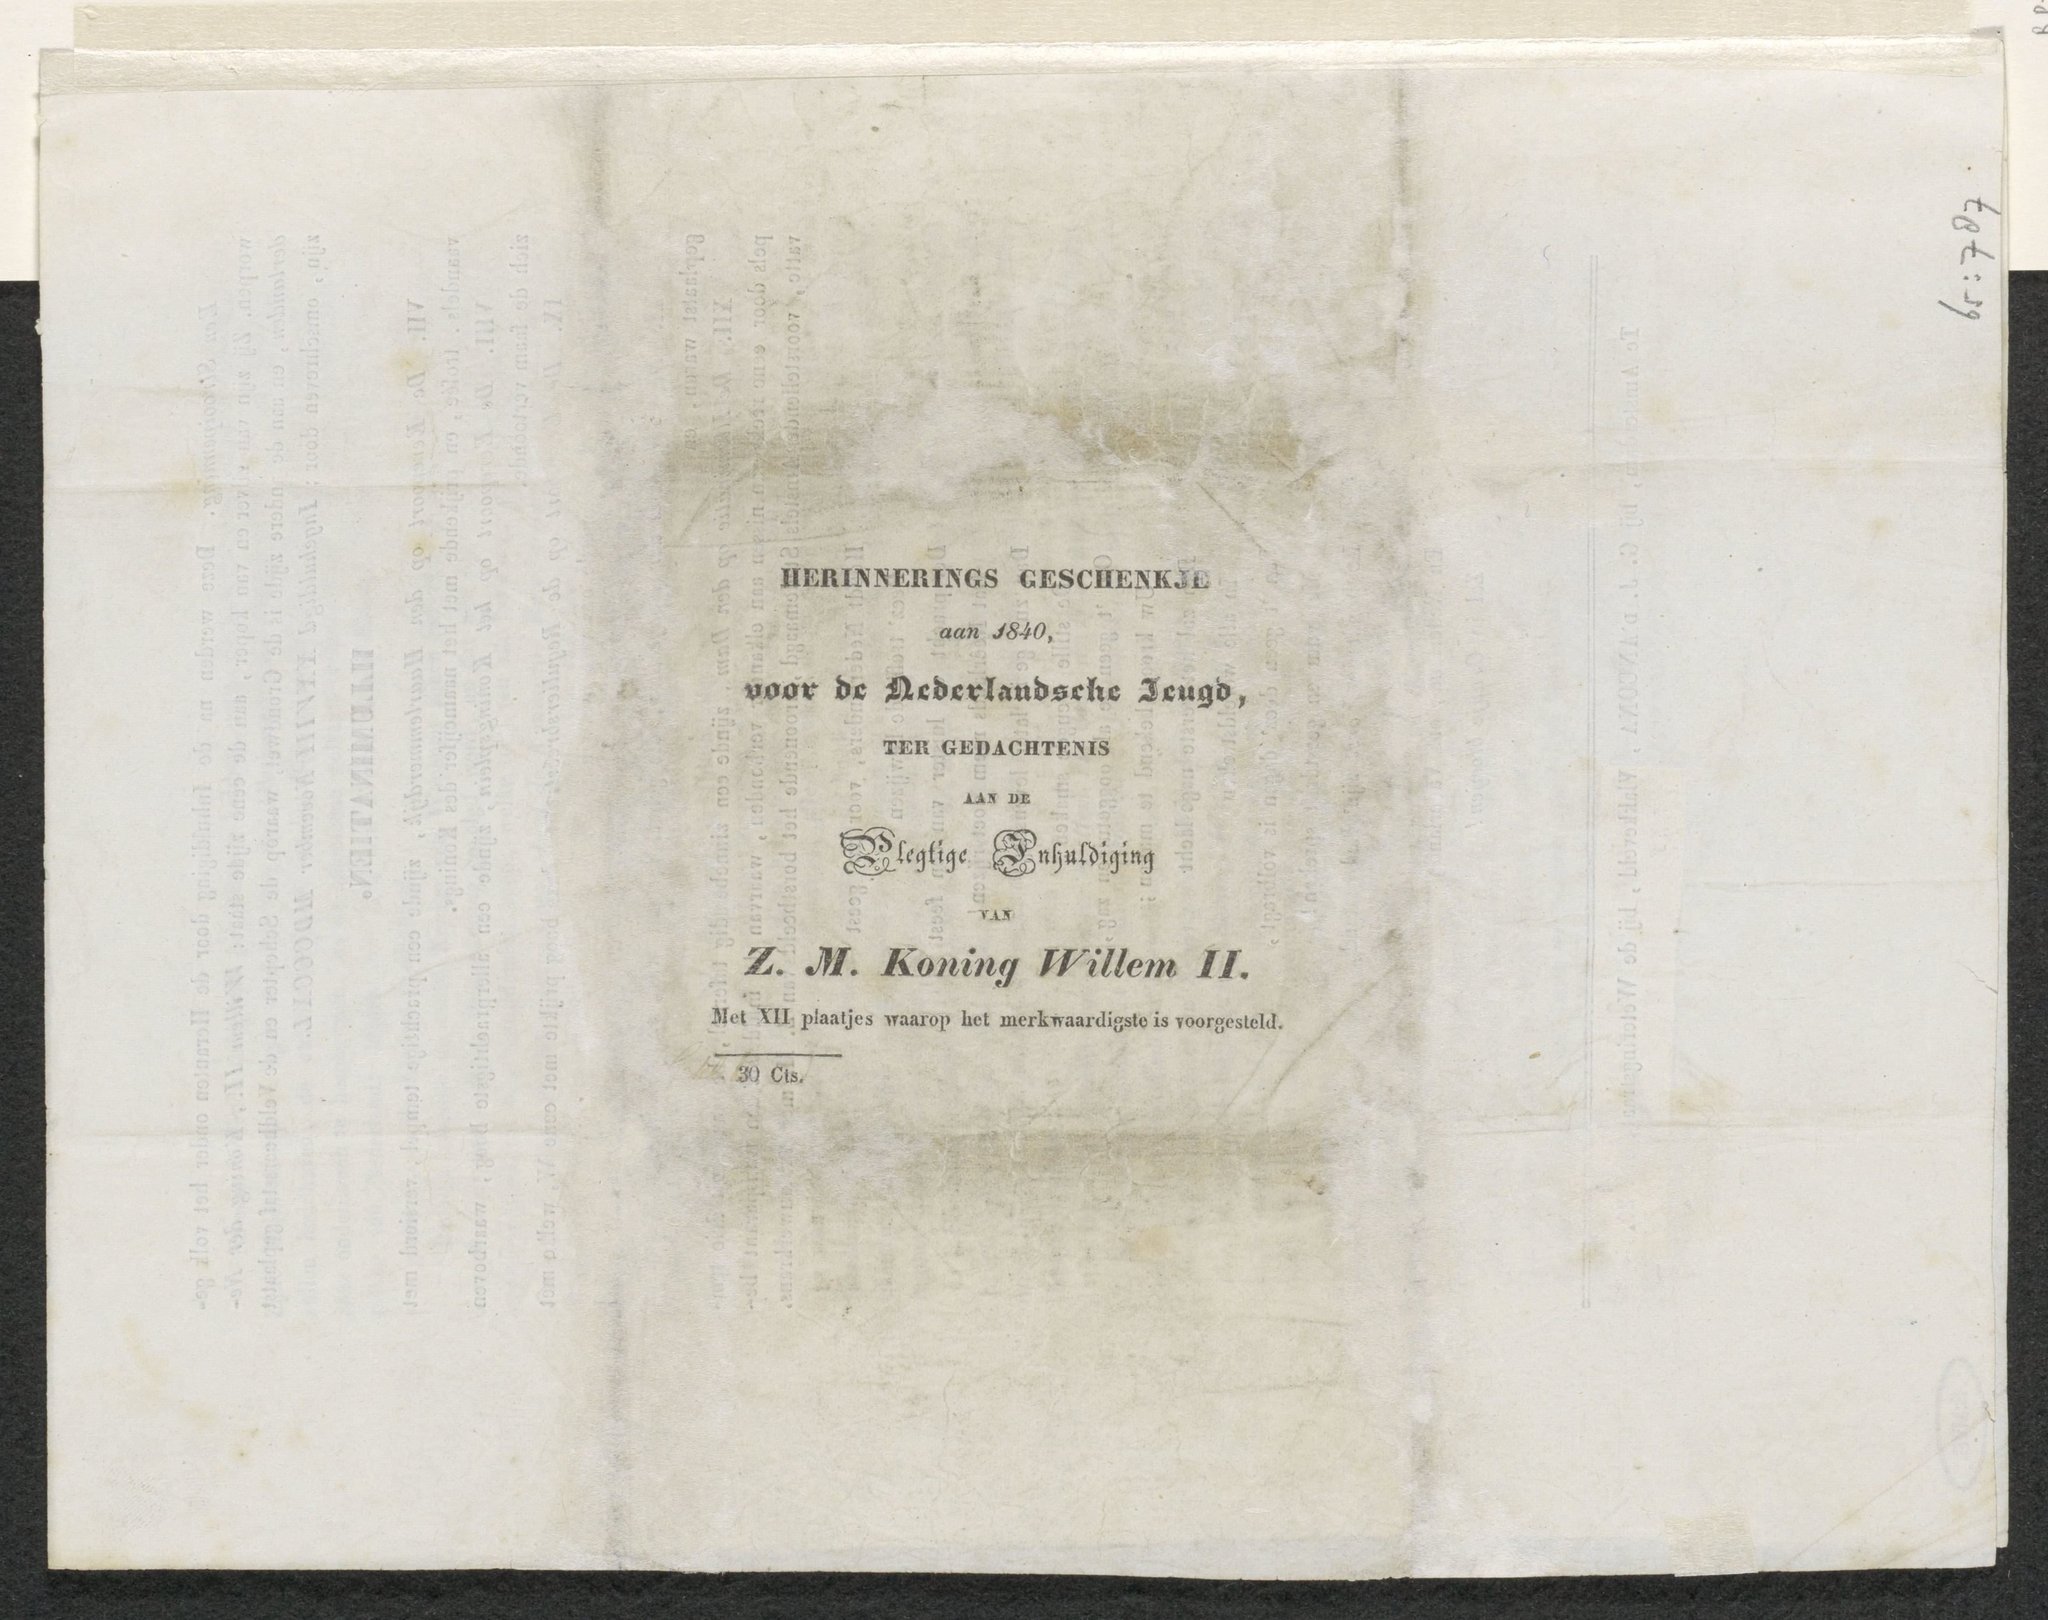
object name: wrapper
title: Herinnerings Geschenkje aan 1840, voor de Nederlandsche Jeugd, ter gedachtenis aan de Plegtige Inhuldiging van Z.M. Koning Willem II. Met XII plaatjes waarop het merkwaardigste is voorgesteld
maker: georgius jacobus d ancona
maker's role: bookseller, publisher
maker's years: 1803-1850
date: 1840-1841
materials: paper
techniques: letterpress printing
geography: amsterdam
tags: the hague, william ii of the netherlands, other forms of installation, amsterdam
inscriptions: collector's mark: Lugt 2228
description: Omslag voor een groep van twaalf prenten met voorstellingen van de belangrijkste momenten tijdens de intocht van Willem II, de erepoorten opgericht in de stad en de inhuldiging op 28 november 1840 in de Nieuwe Kerk te Amsterdam. Dubbelgevouwen blad met een oproep aan 'Neêrlands Jeugd!', een lijst van de prenten I-XII en een gedicht. Het blad kan als een envelop om de prentjes heen dichtgevouwen worden.